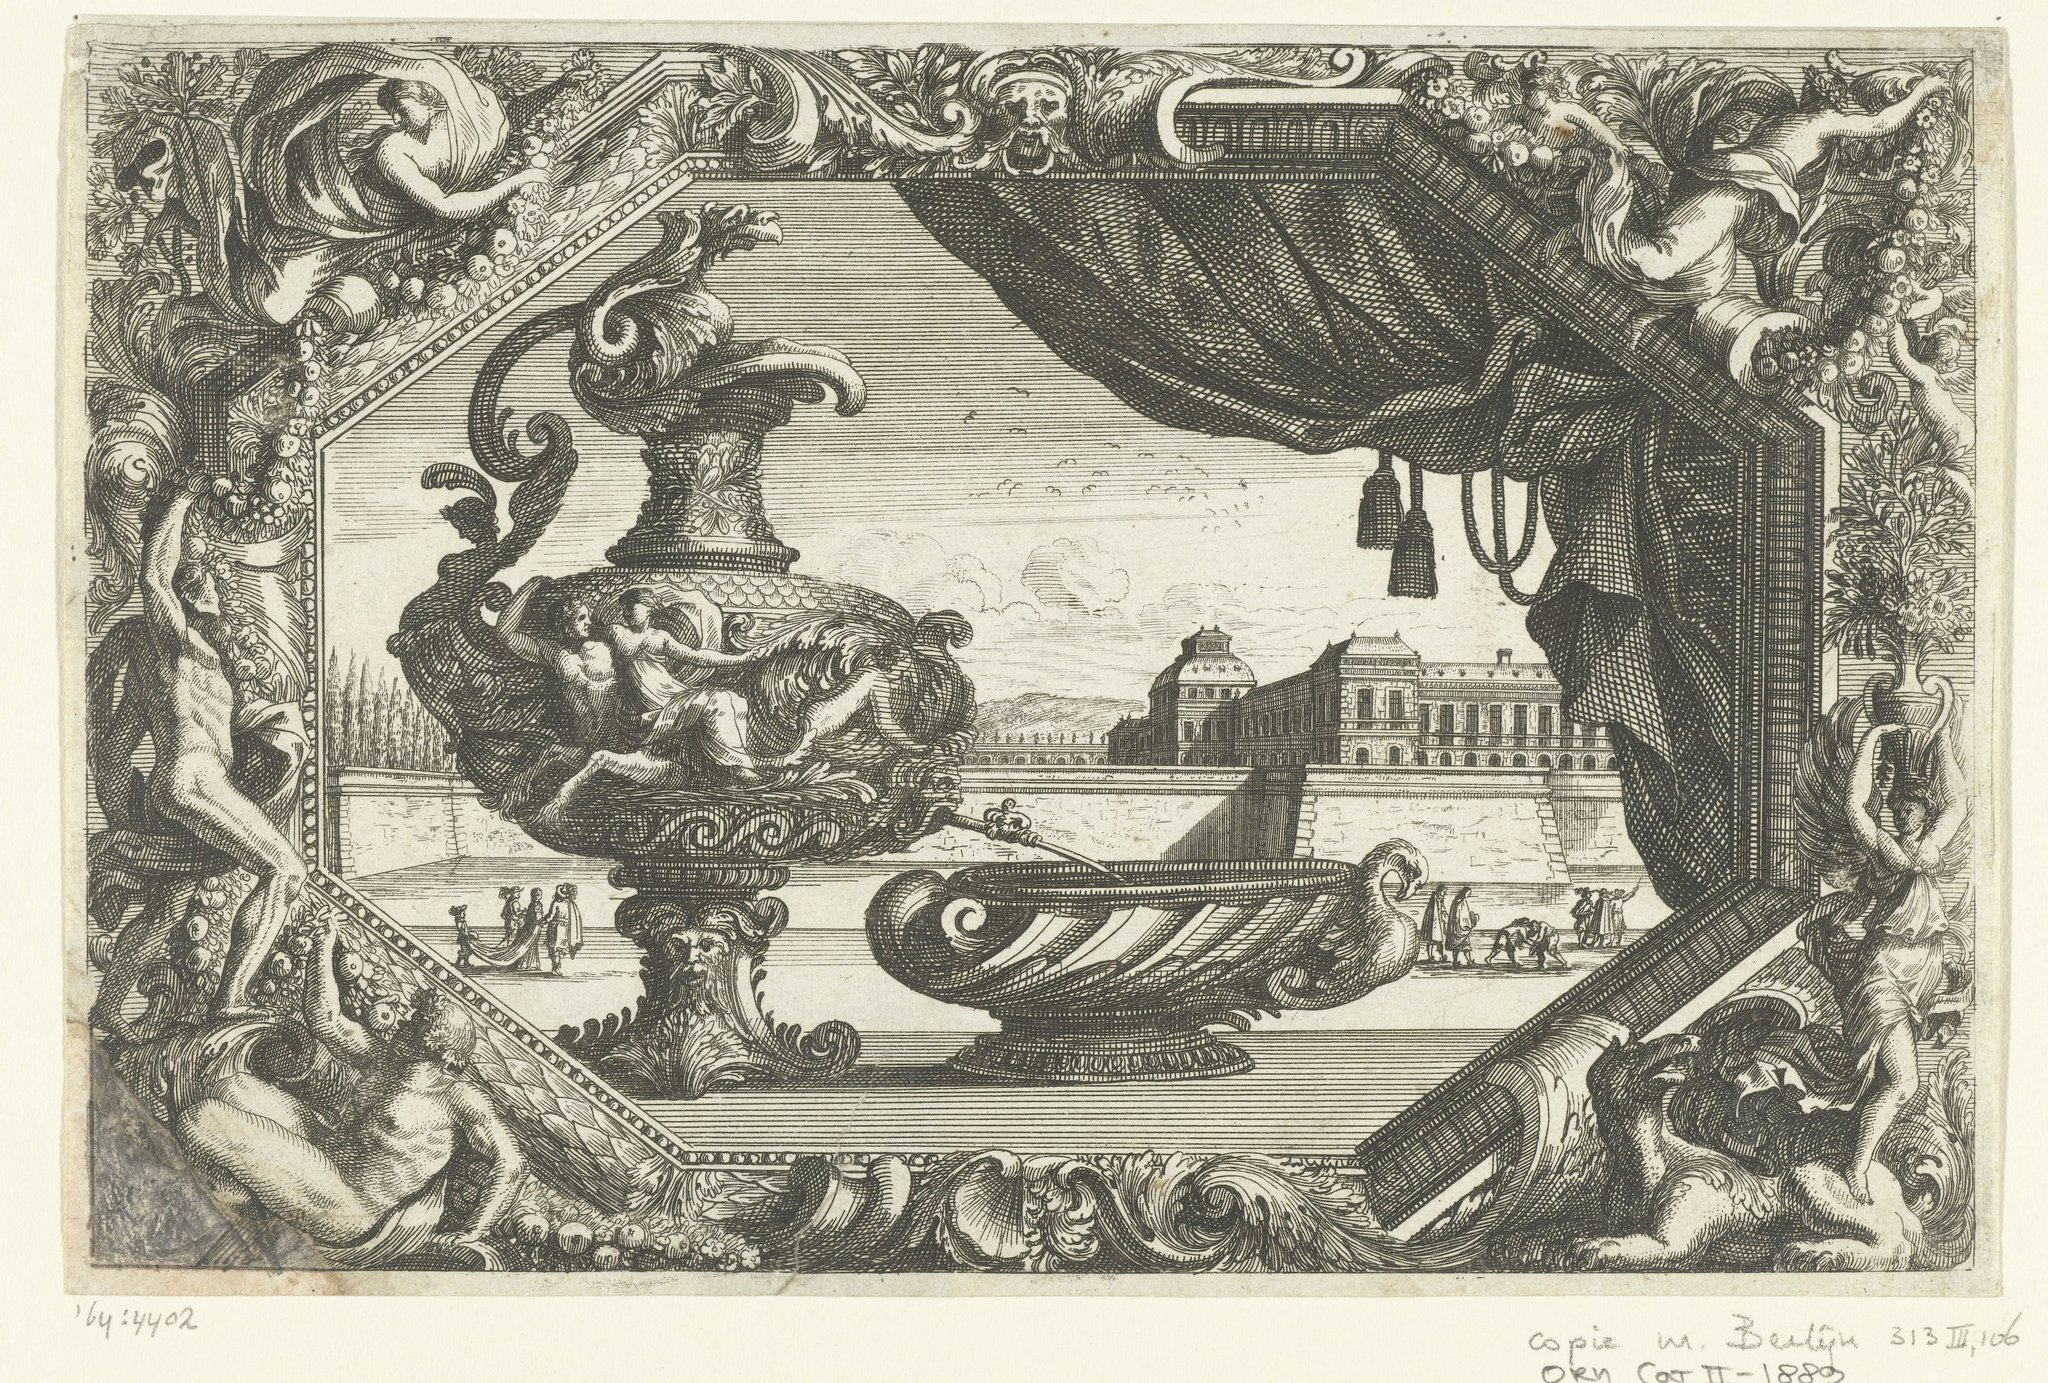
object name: ornament print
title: Vasi Diversi e Ornamenti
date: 1687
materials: paper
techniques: etching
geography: netherlands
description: Het bassin heeft twee handvatten in de vorm van een zwaan en een schelp. Uit serie van 6 bladen.